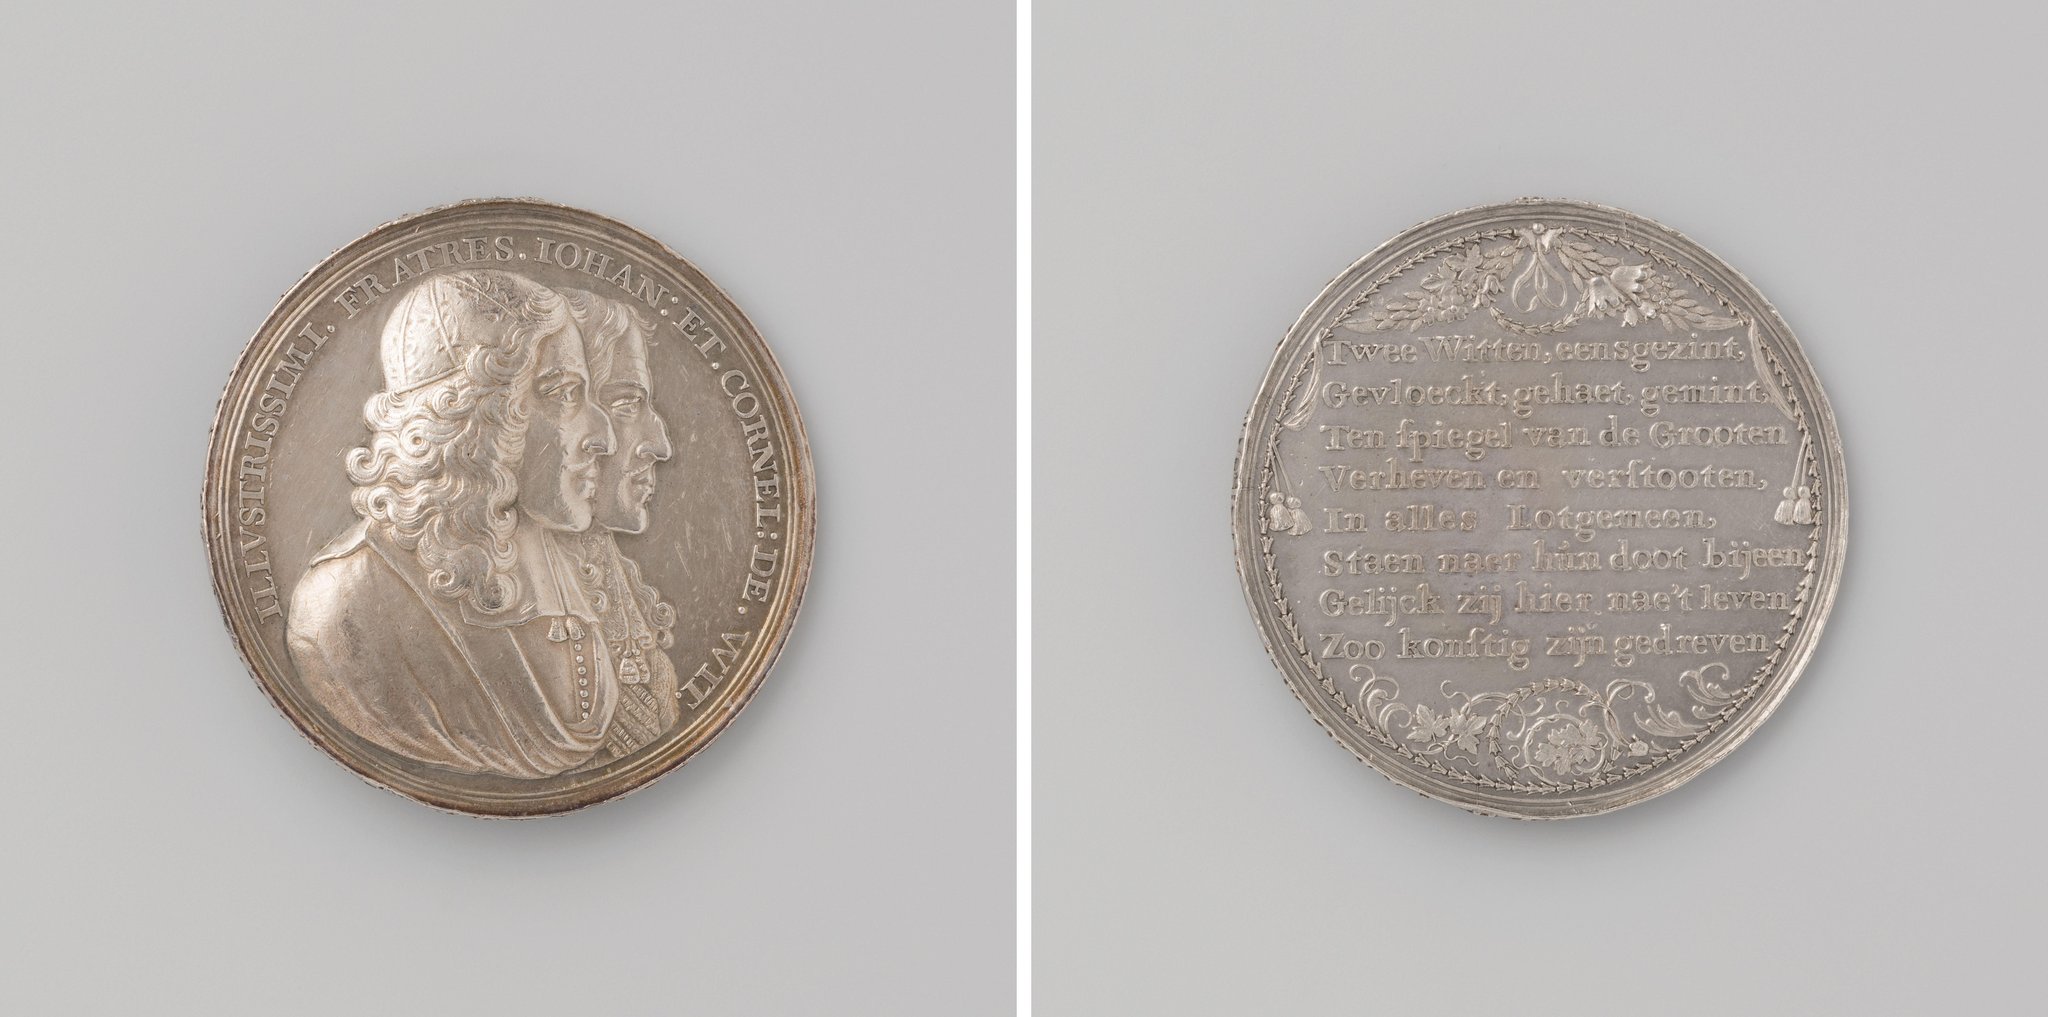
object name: history medal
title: Moord op de gebroeders de Witt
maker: Anonymous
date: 1672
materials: silver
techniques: striking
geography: netherlands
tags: dordrecht, the hague, cornelis de witt, politician, johan de witt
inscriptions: edge inscription: ‘VIOLENTA MORTE DELETI HAGÆ COMITIS.20.AVG. A.O. 1672.’, circumscription: ‘ILLVSTRISSIMI.FRATRES.IOHAN:ET.CORNEL: DE.WIT.’, inscription: ‘Twee witten,eensgezint,/Gevloeckt,geahet,gemint,/Ten spiegel van de Grooten/Verheven en verstooten,/In alles lotgemeen,/Staen naer hun doot bijeen/Gelijck zij hier na't leven/Zoo konstig zijn gedreven’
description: Zilveren penning. Voorzijde: borststuk van de gebroeders de Witt binnen omschrift. Keerzijde: opschrift onder twee bloemtrossen; randschrift.